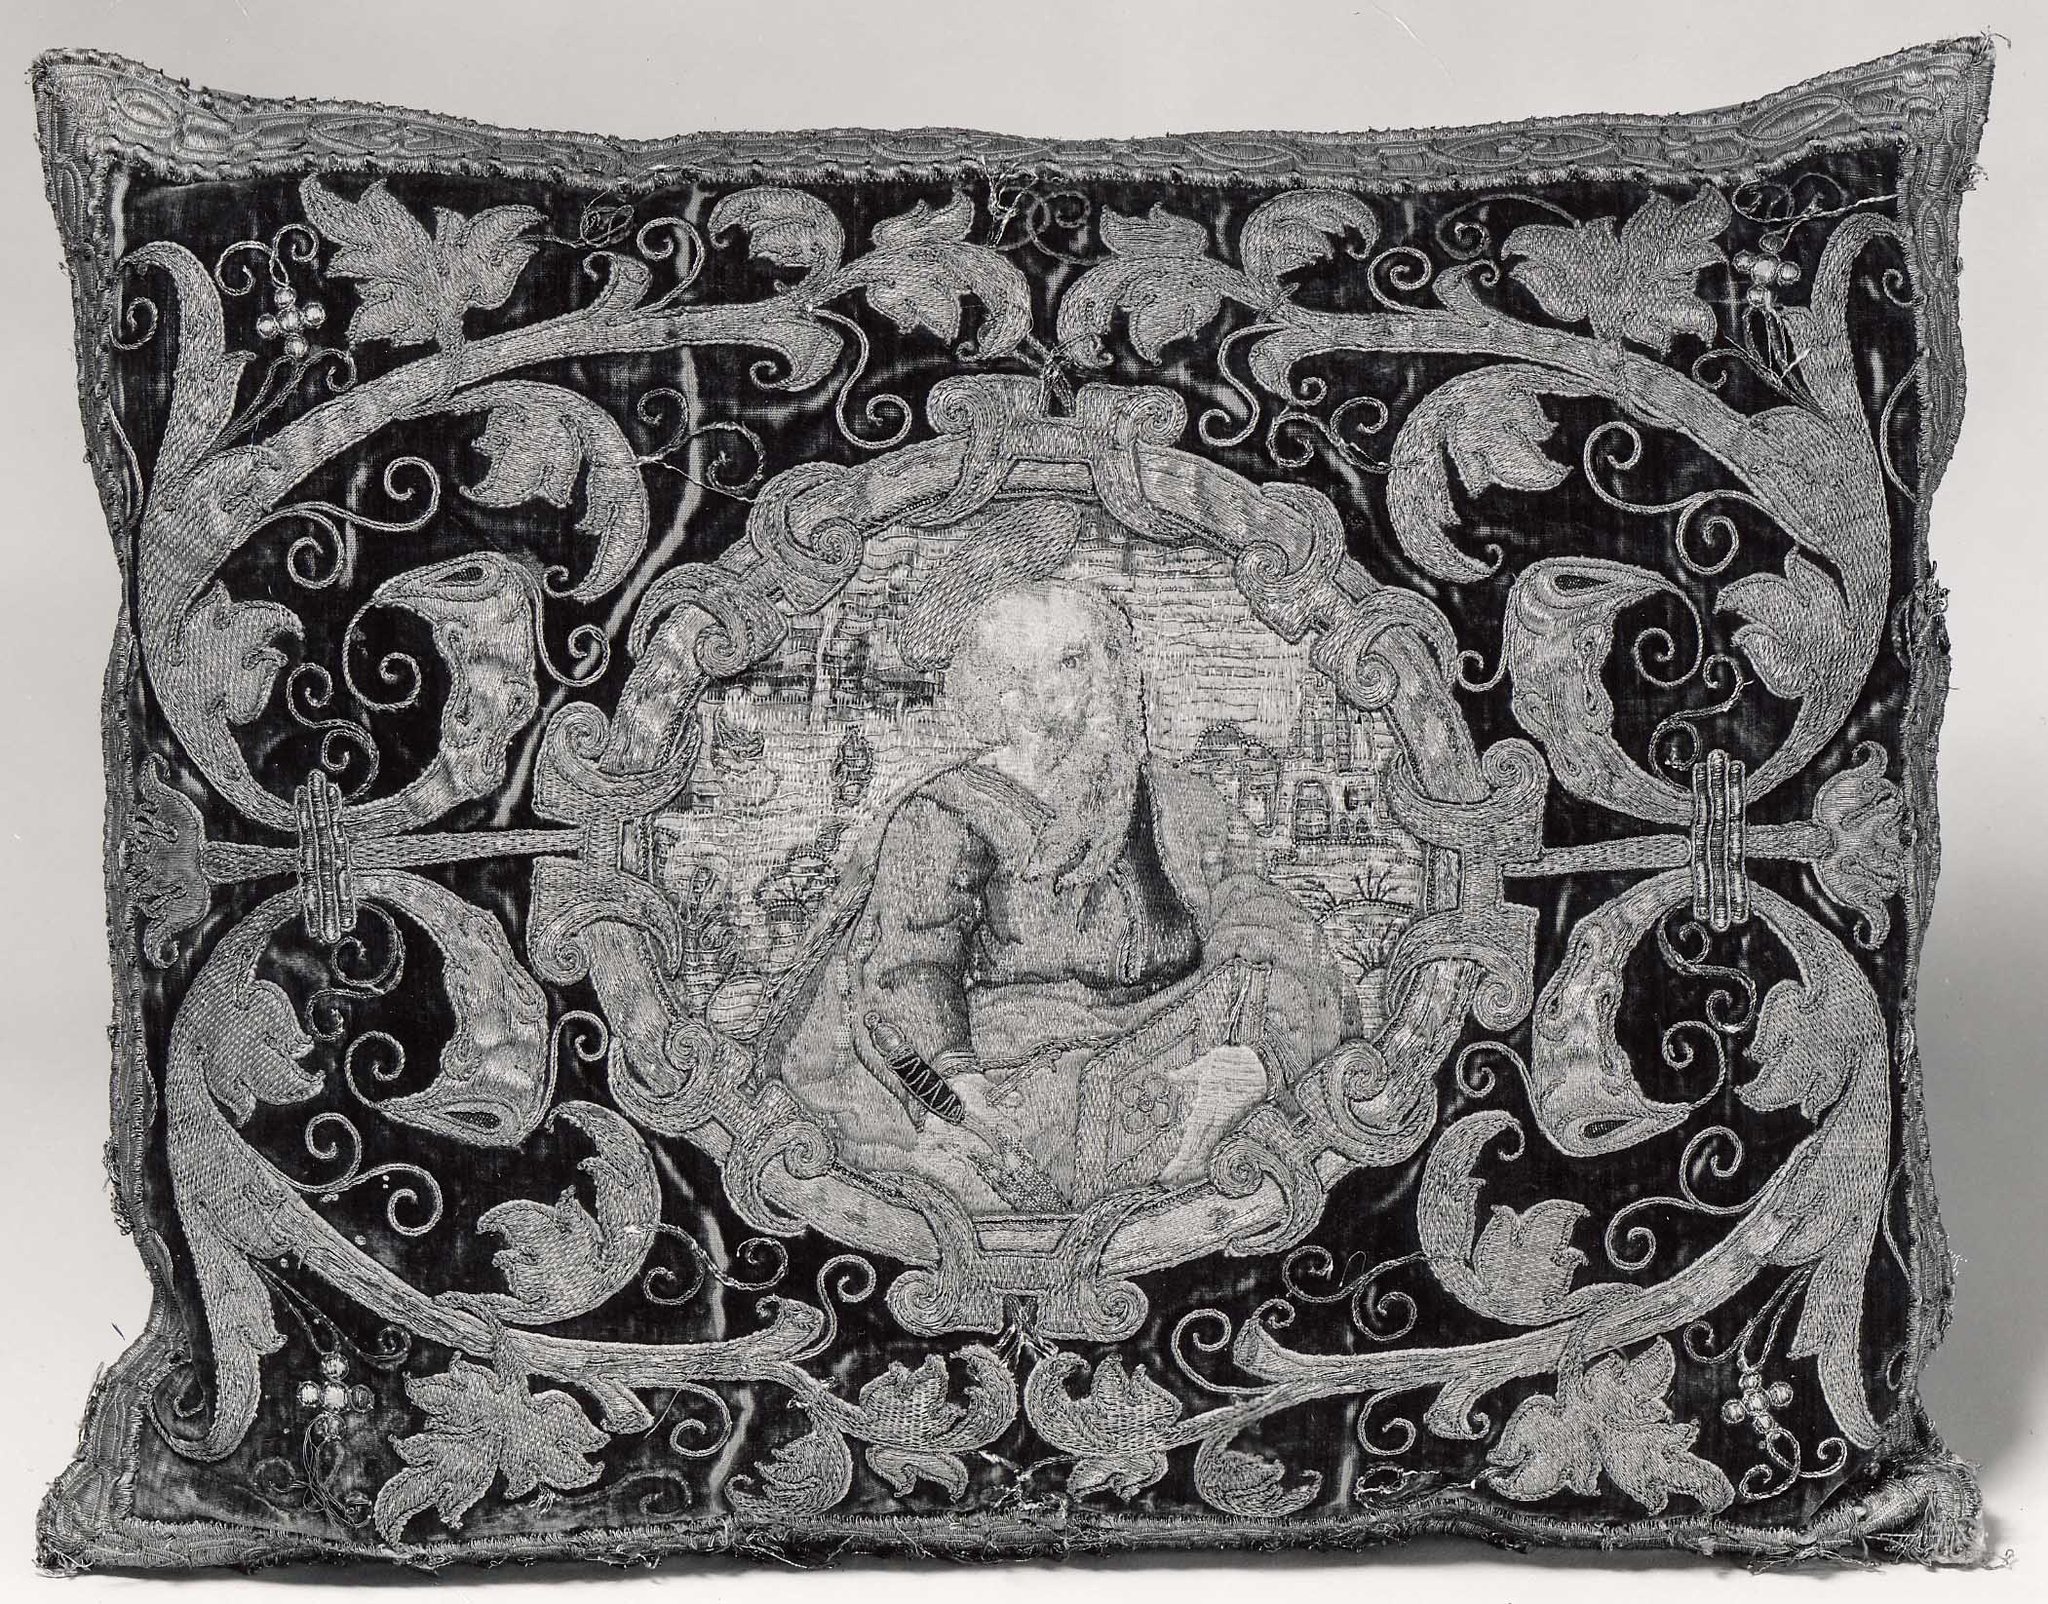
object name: clothing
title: Apparel made into cushion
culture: spanish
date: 1601-1700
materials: hemp, linen, metal, silk, wool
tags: men,saints